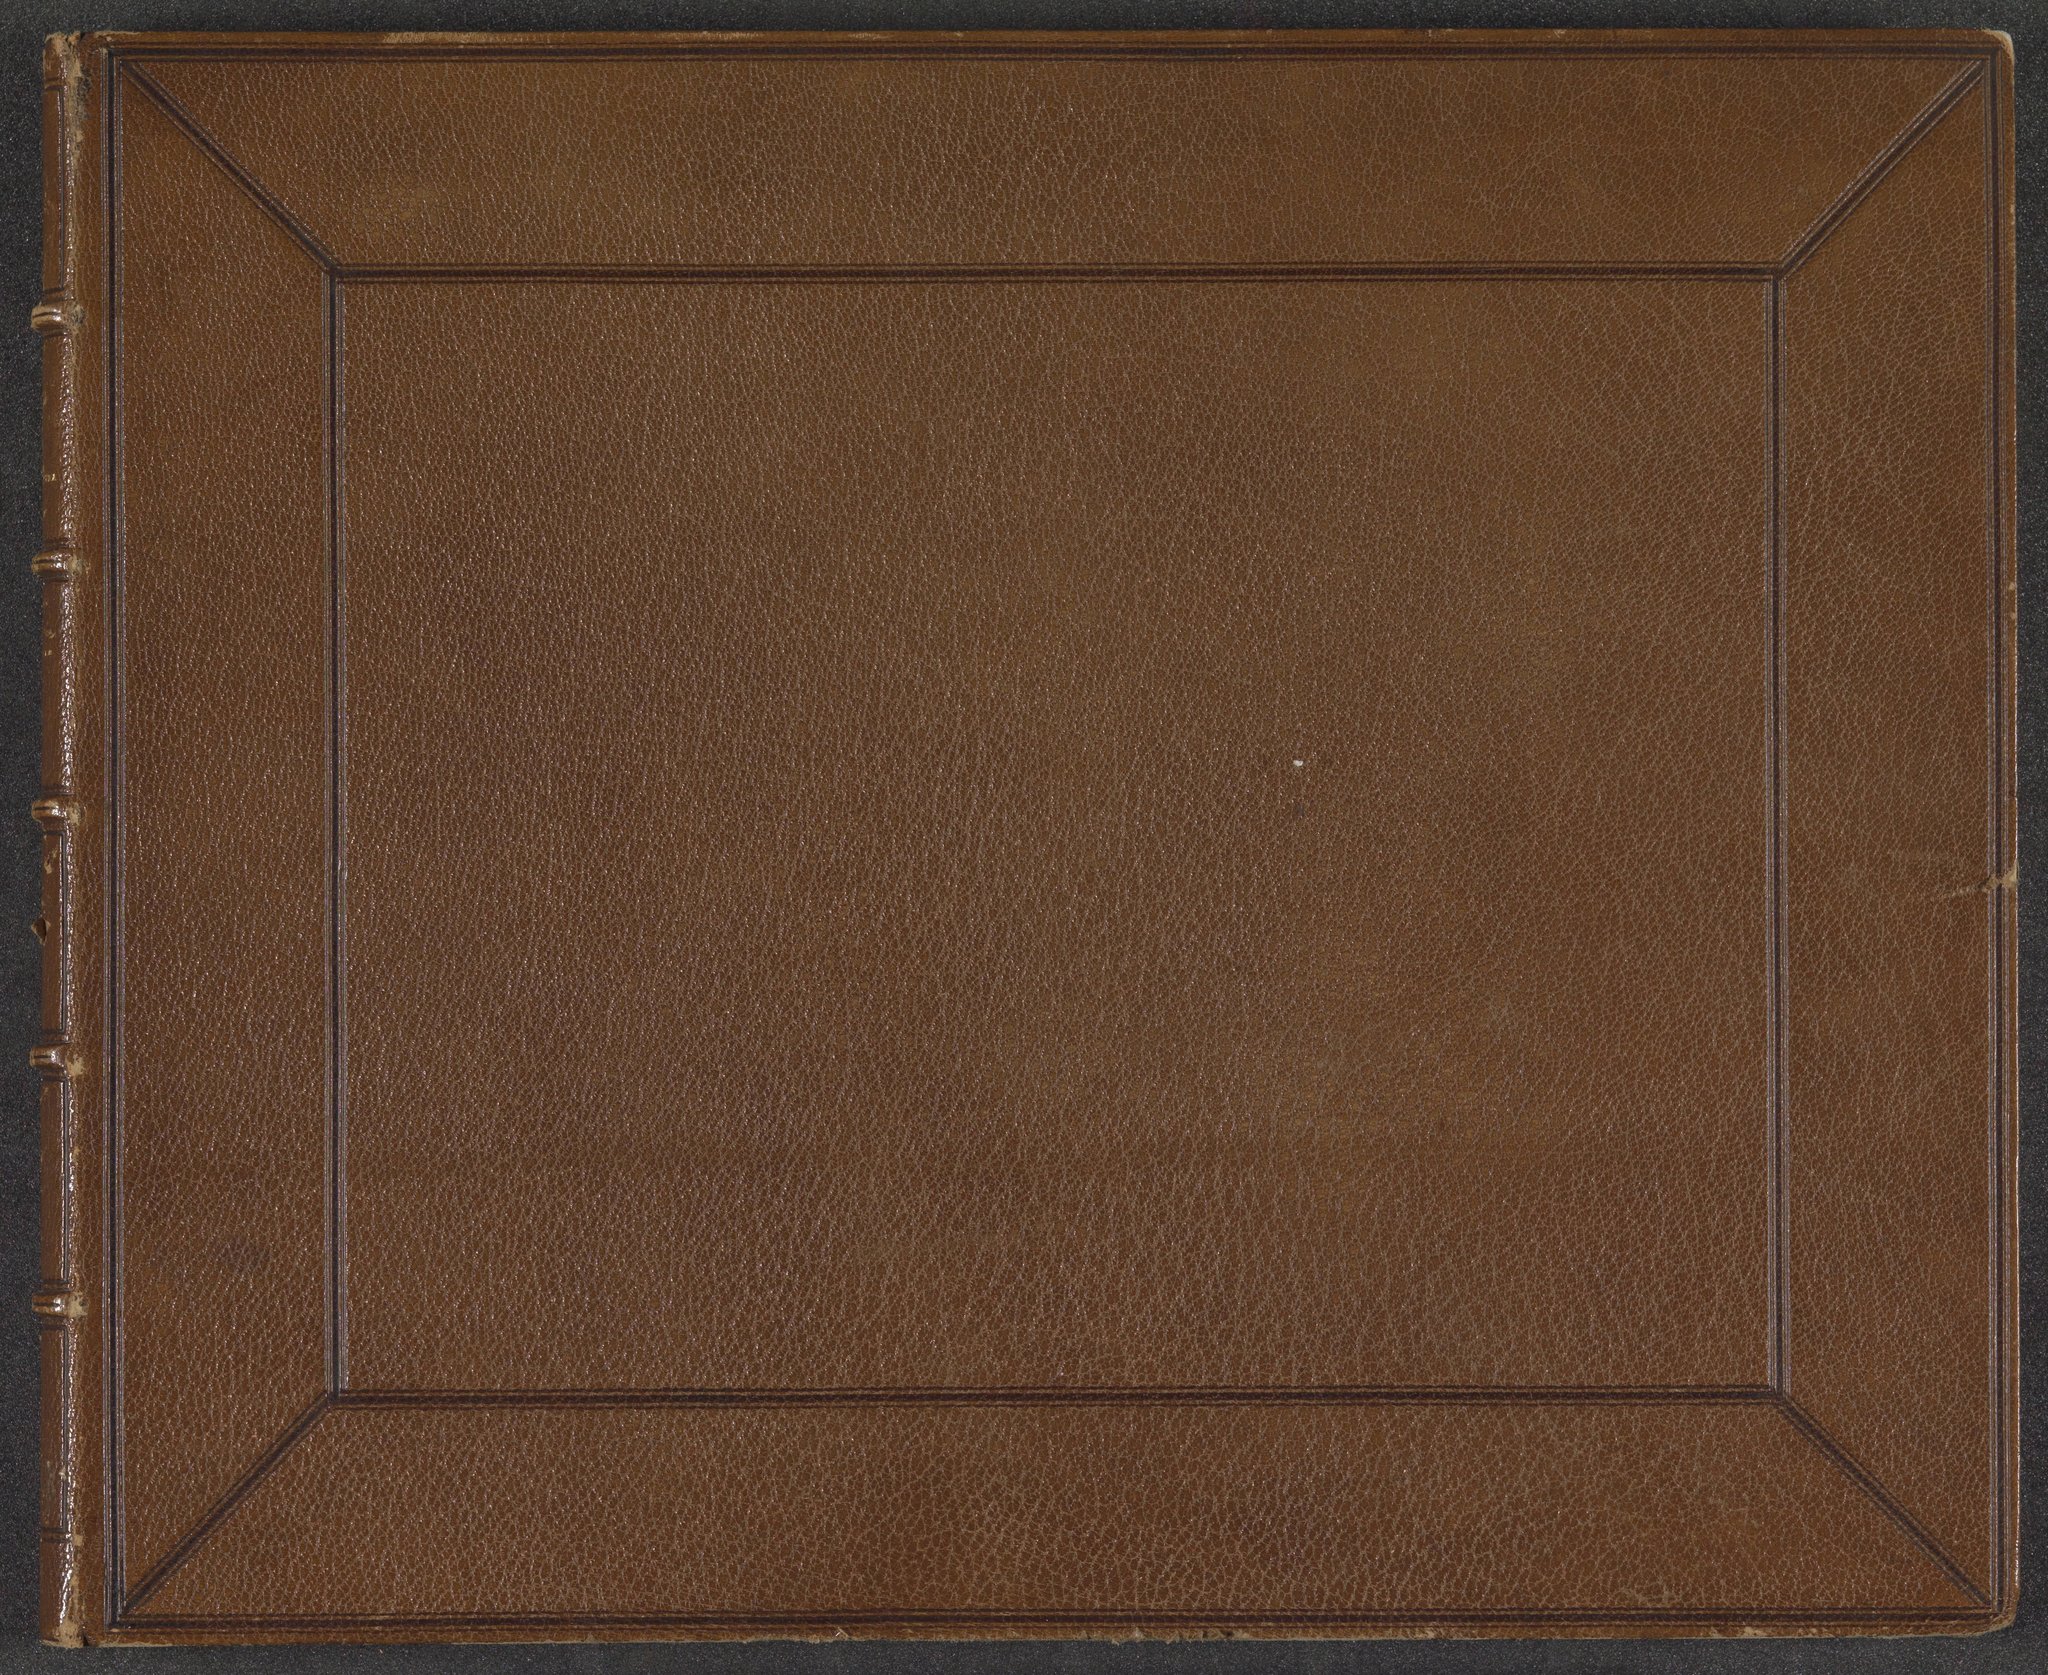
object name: prentrecueil, prentenalbum, prentalbum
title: Architectura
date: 1601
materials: leather, paper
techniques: bookbinding, decorated paper, etching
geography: antwerp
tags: well, civic architecture; edifices; dwellings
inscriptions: label: ‘Legaat Godefroy / No 797’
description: Album met 46 voorstellingen op 45 albumbladen. Het album bevat de serie getiteld: Variae Architecturae Formae. Ze bestaat uit een titelprent en eenentwintig architectuurperspectieven in ovale omlijsten voor intarsia. De eerste prent uit de reeks komt twee keer voor. Daarnaast een serie van vierentwintig waterputten. Bruin marokijnen band met voorin en achterin twee schutbladen.